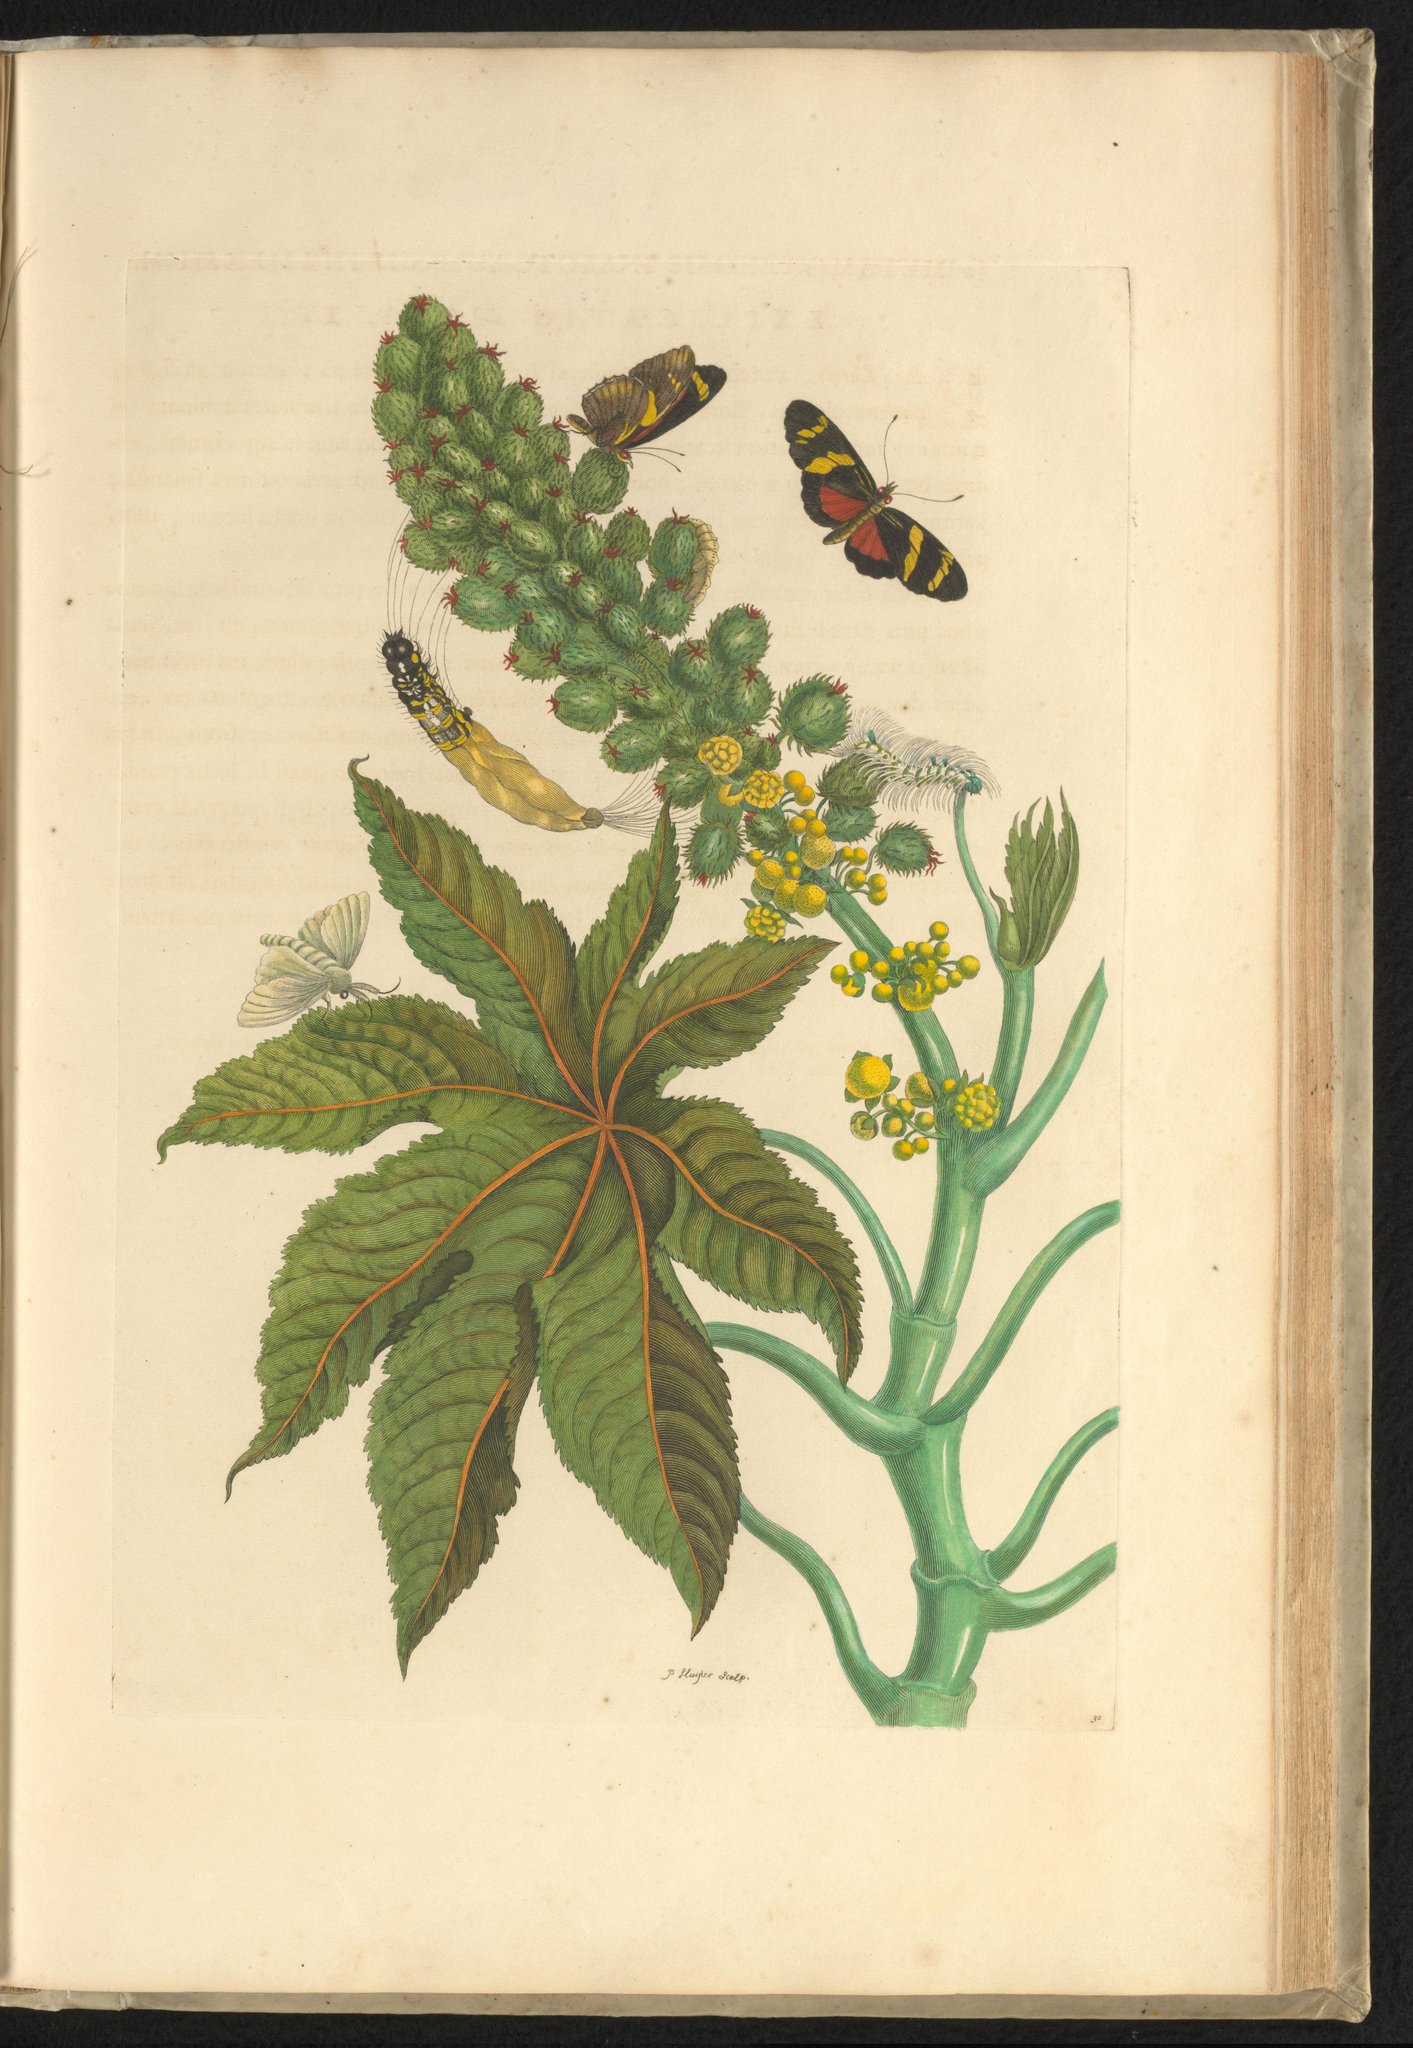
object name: page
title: Wonderboom (Ricinus communis) met vlinders, nachtvlinder en rups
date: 1705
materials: paper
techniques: etching, hand coloring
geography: suriname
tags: insects: moth, insects: butterfly, insects: caterpillar, plants and herbs, suriname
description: Rechtsonder genummerd: 30. Prent maakt deel uit van een boek.